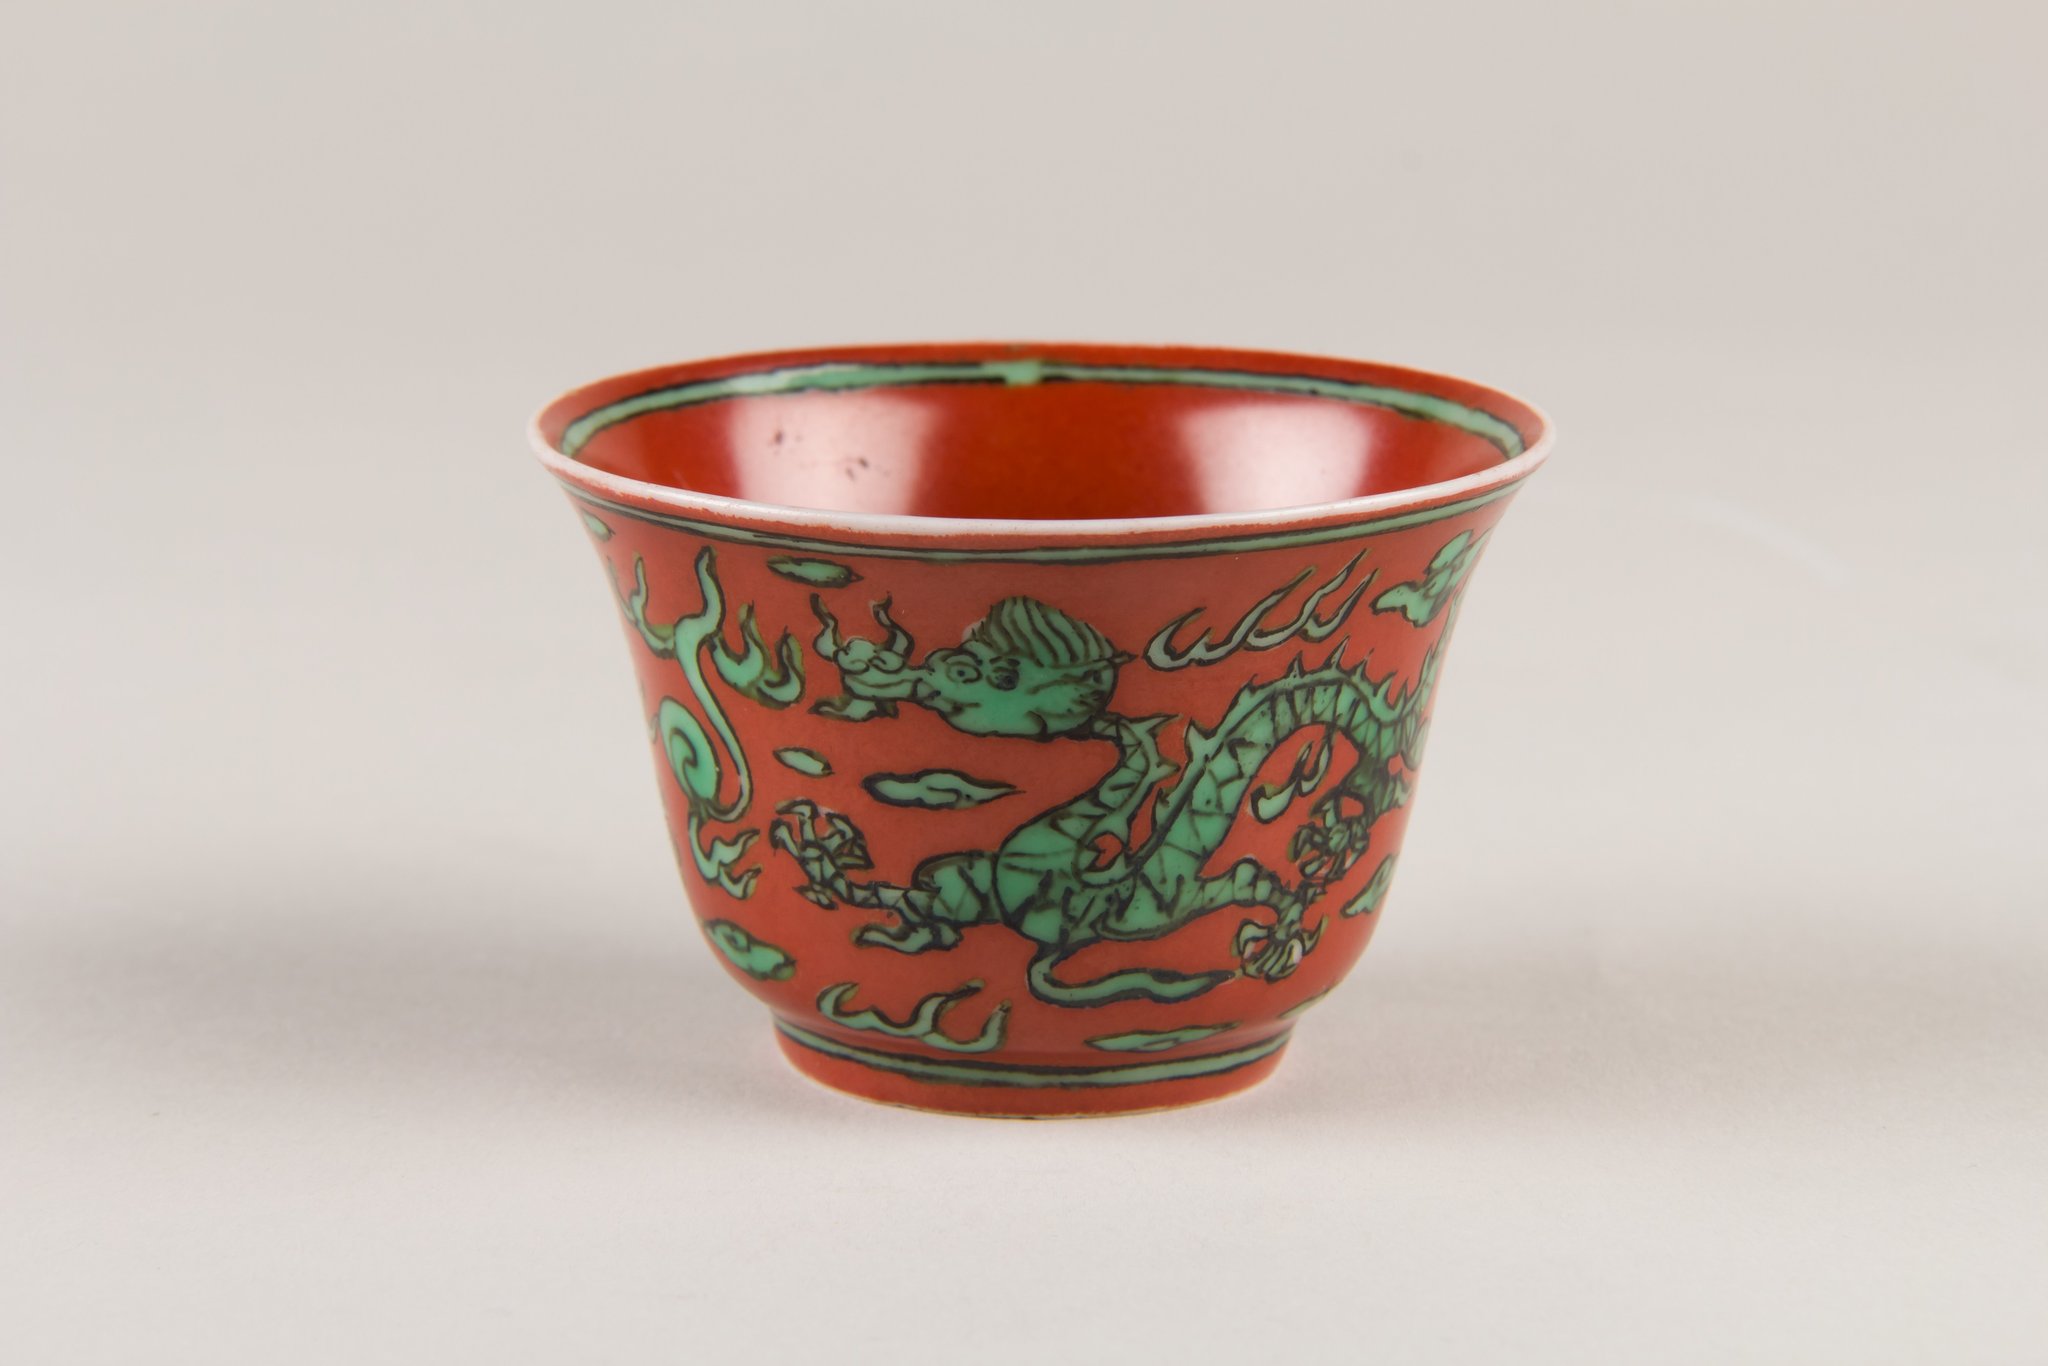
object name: cup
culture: chinese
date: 1522-1566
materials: porcelain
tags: dragons